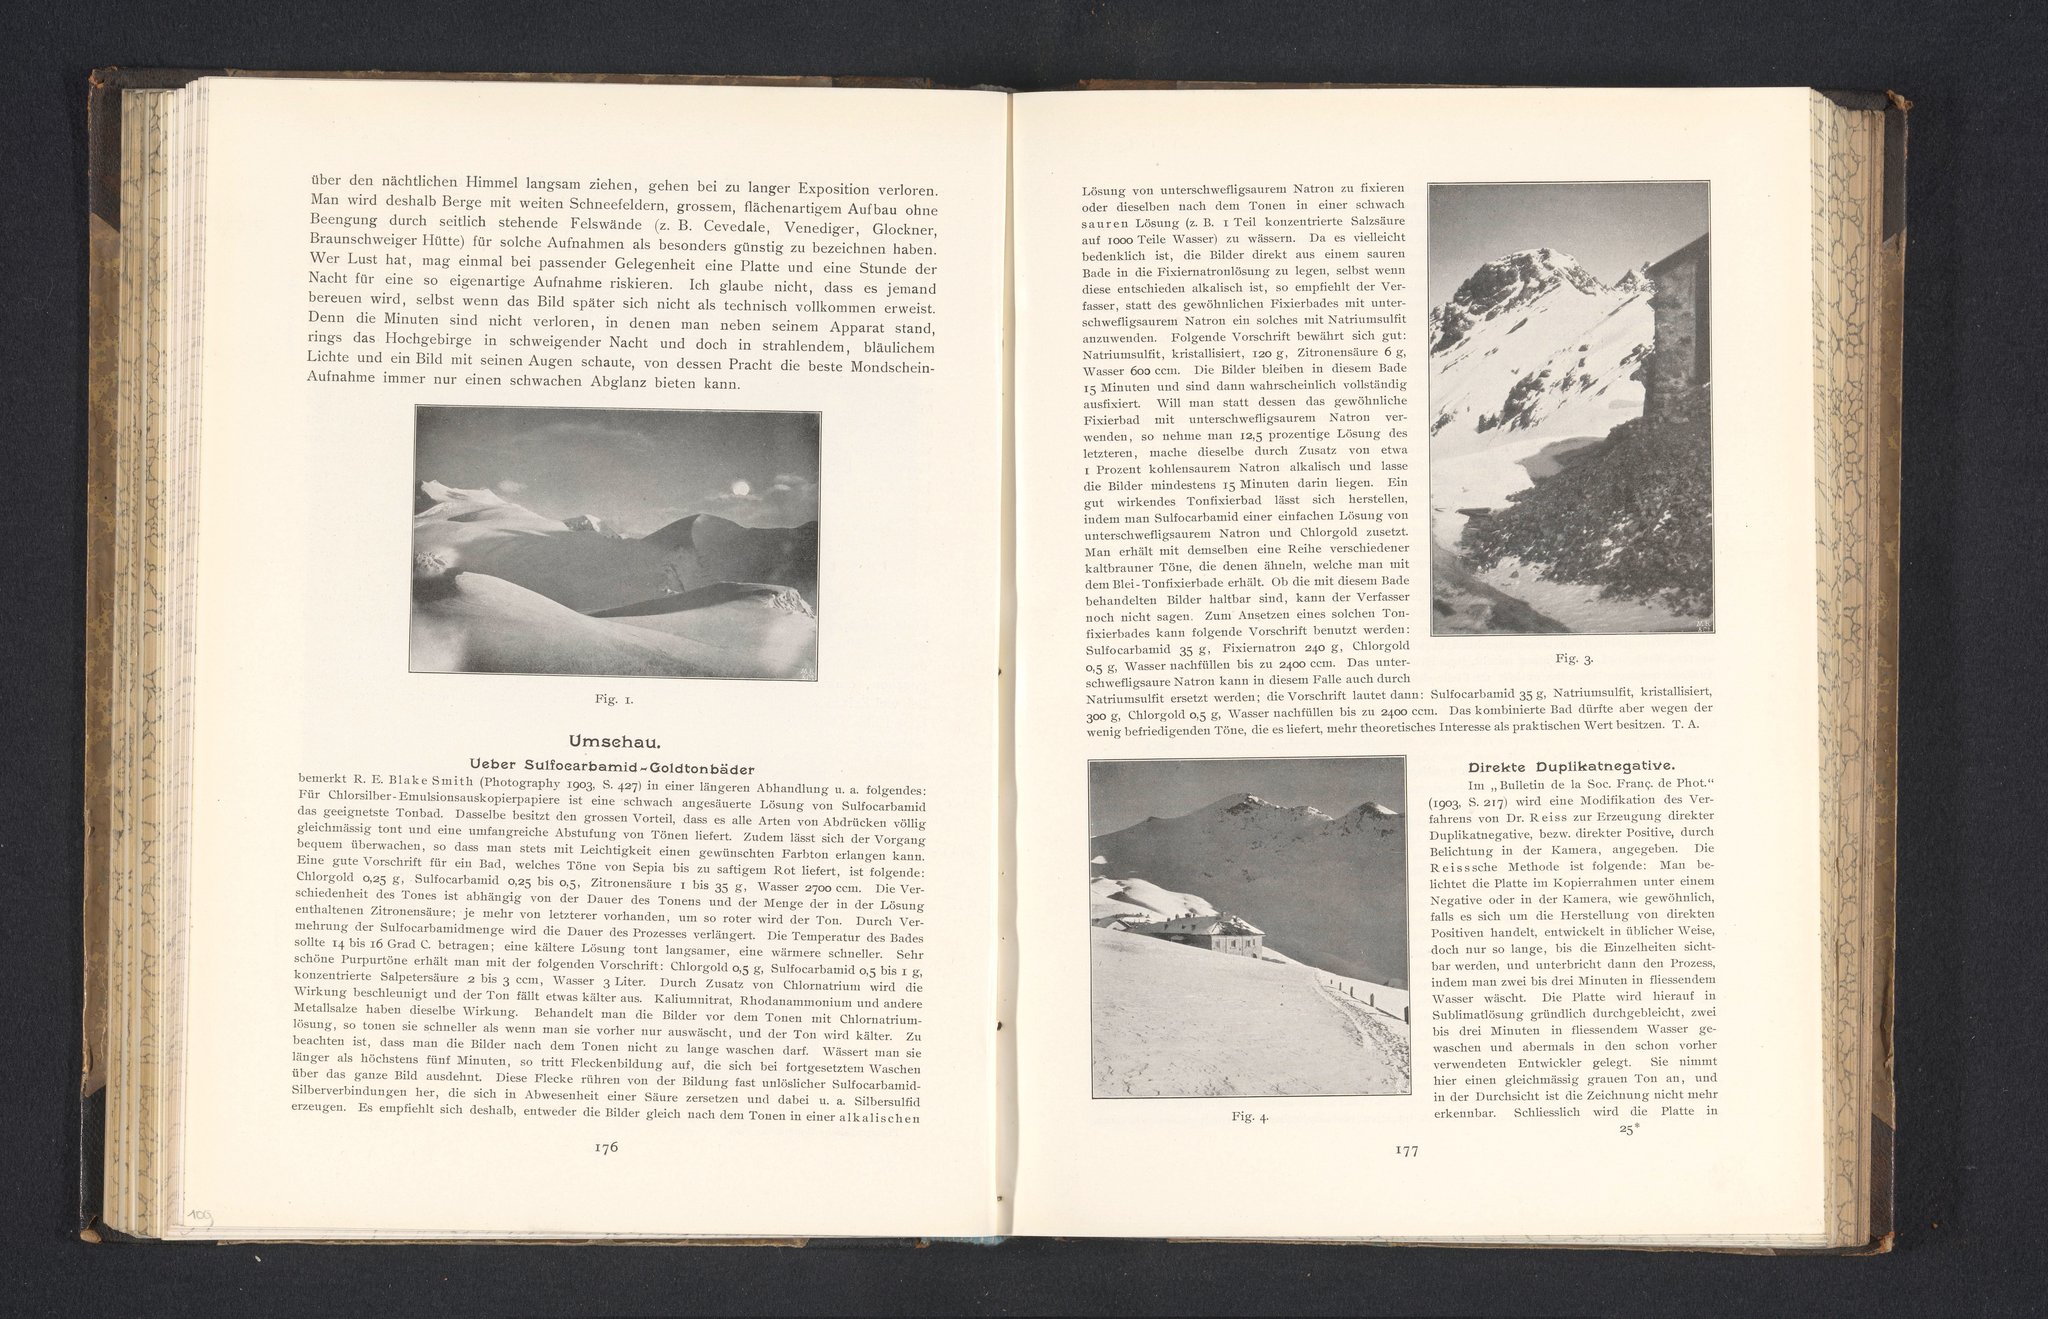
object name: photomechanical print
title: Winters berglandschap met een huis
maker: Anonymous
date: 1898-1903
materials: paper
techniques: autotype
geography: berlin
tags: rural housing, e.g. country-house, villa, cottage, snow, mountains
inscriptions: inscription: ‘Fig. 4’